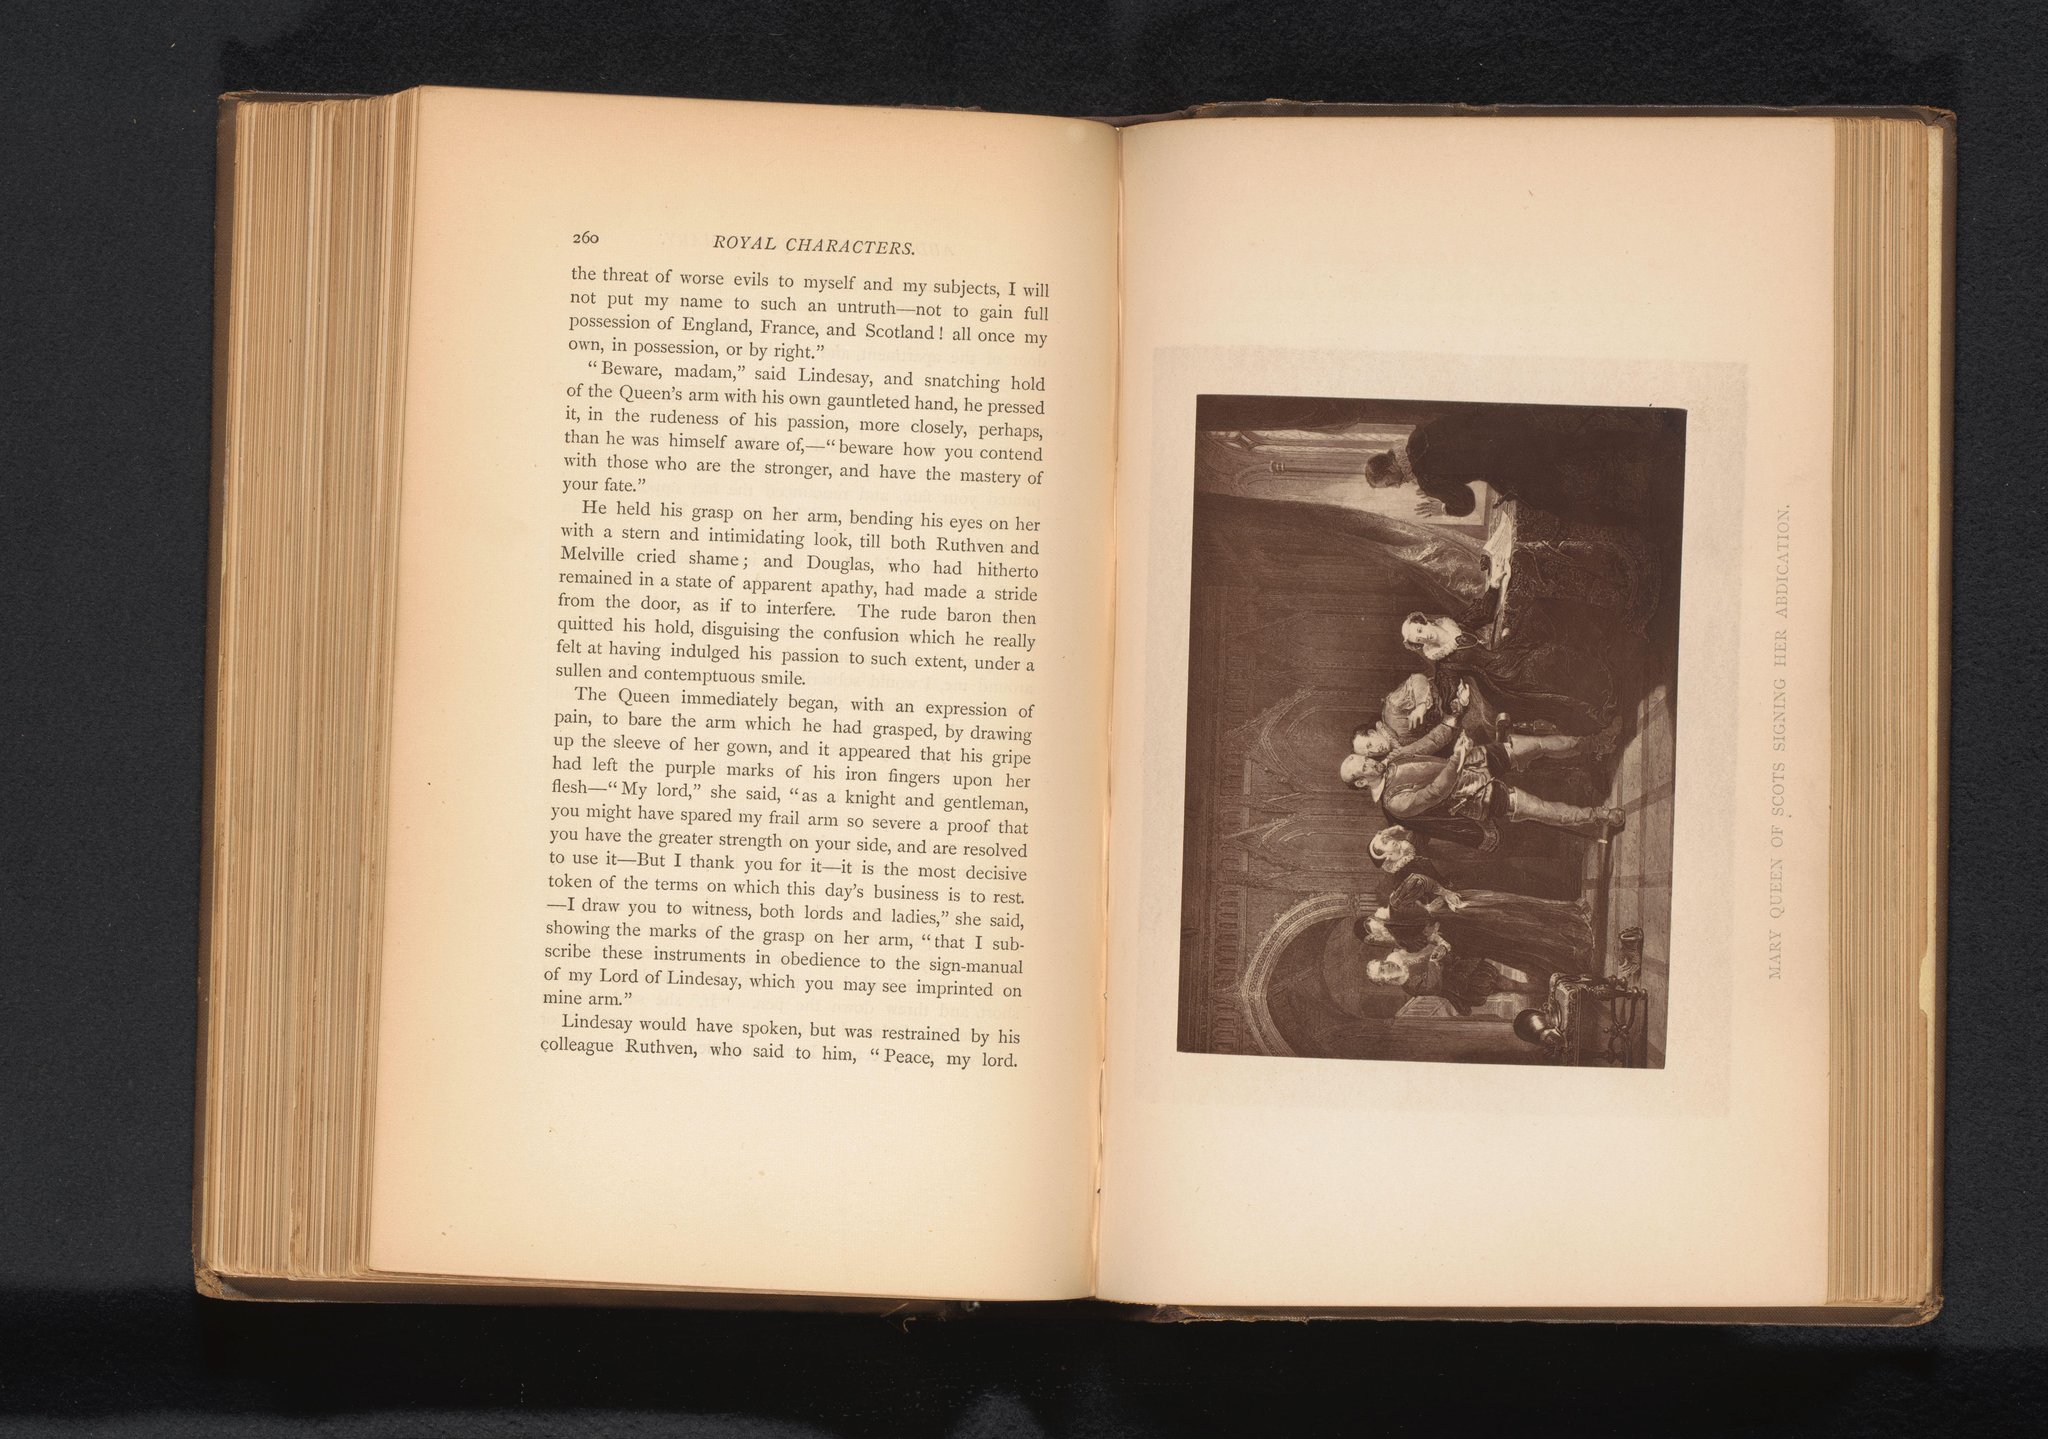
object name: photomechanical print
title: Mary queen of Scots signing her abdication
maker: Anonymous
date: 1876-1881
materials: paper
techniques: woodburytype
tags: abdication (of a ruler) - bb - female ruler, queen